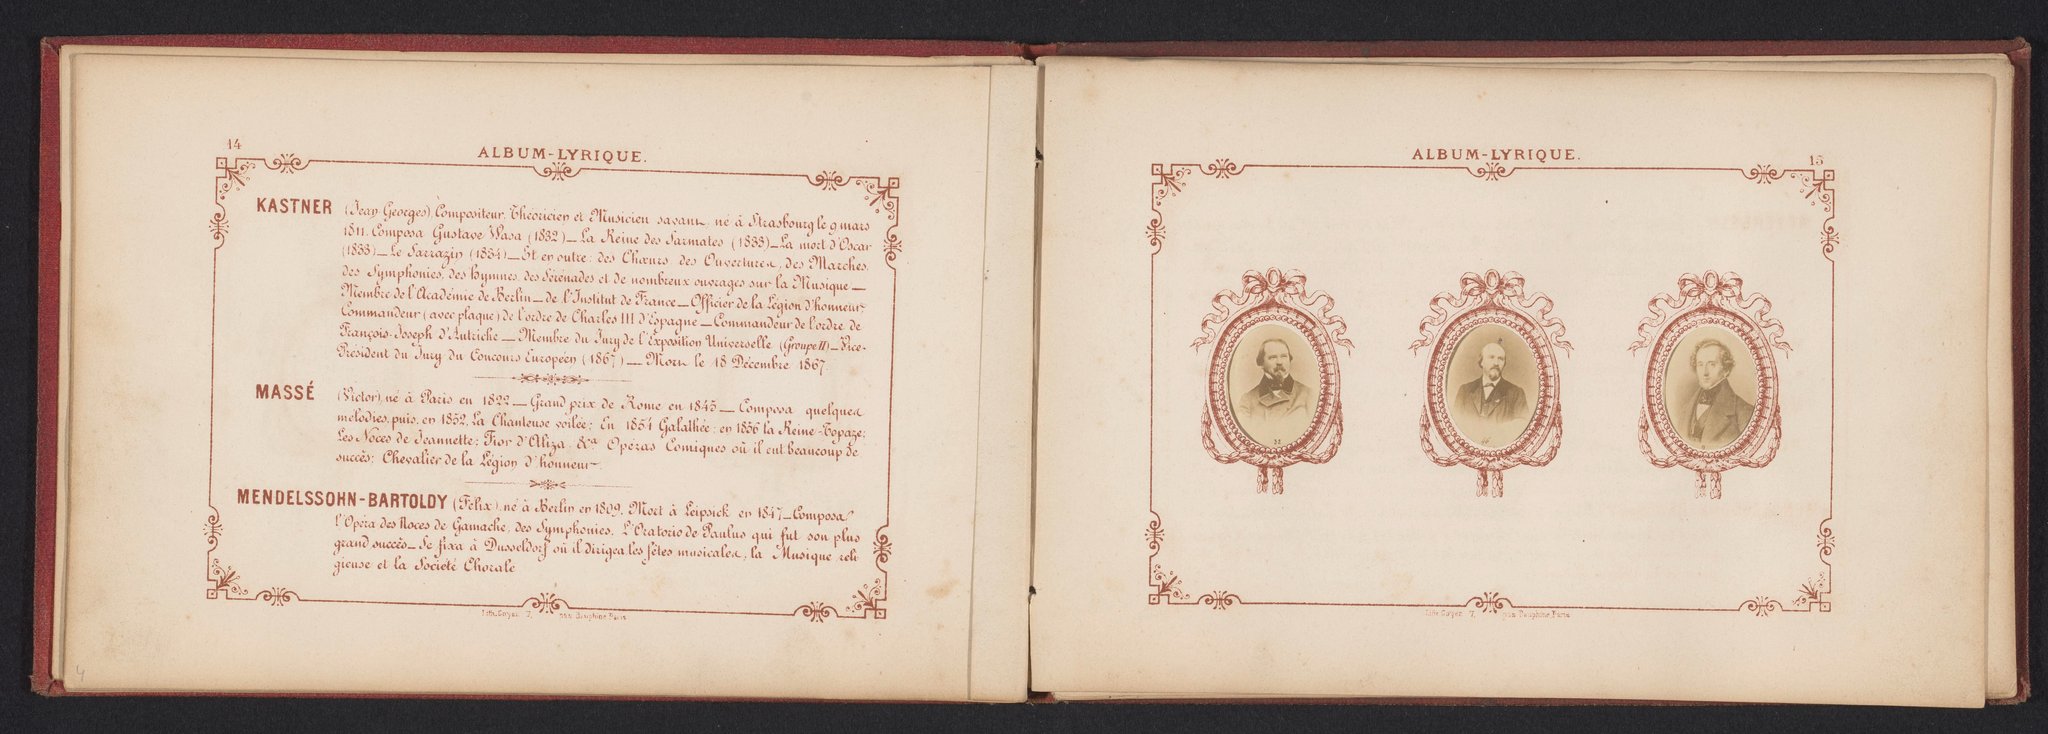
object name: reproduction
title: Drie fotoreproducties, voorstellende portretten van Jean-Georges Kastner, Victor Massé en Felix Mendelssohn Bartholdy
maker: antoine rené trinquart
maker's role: fotograaf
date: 1858-1868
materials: paper, photographic support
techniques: albumen print, printing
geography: france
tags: vienna, composer